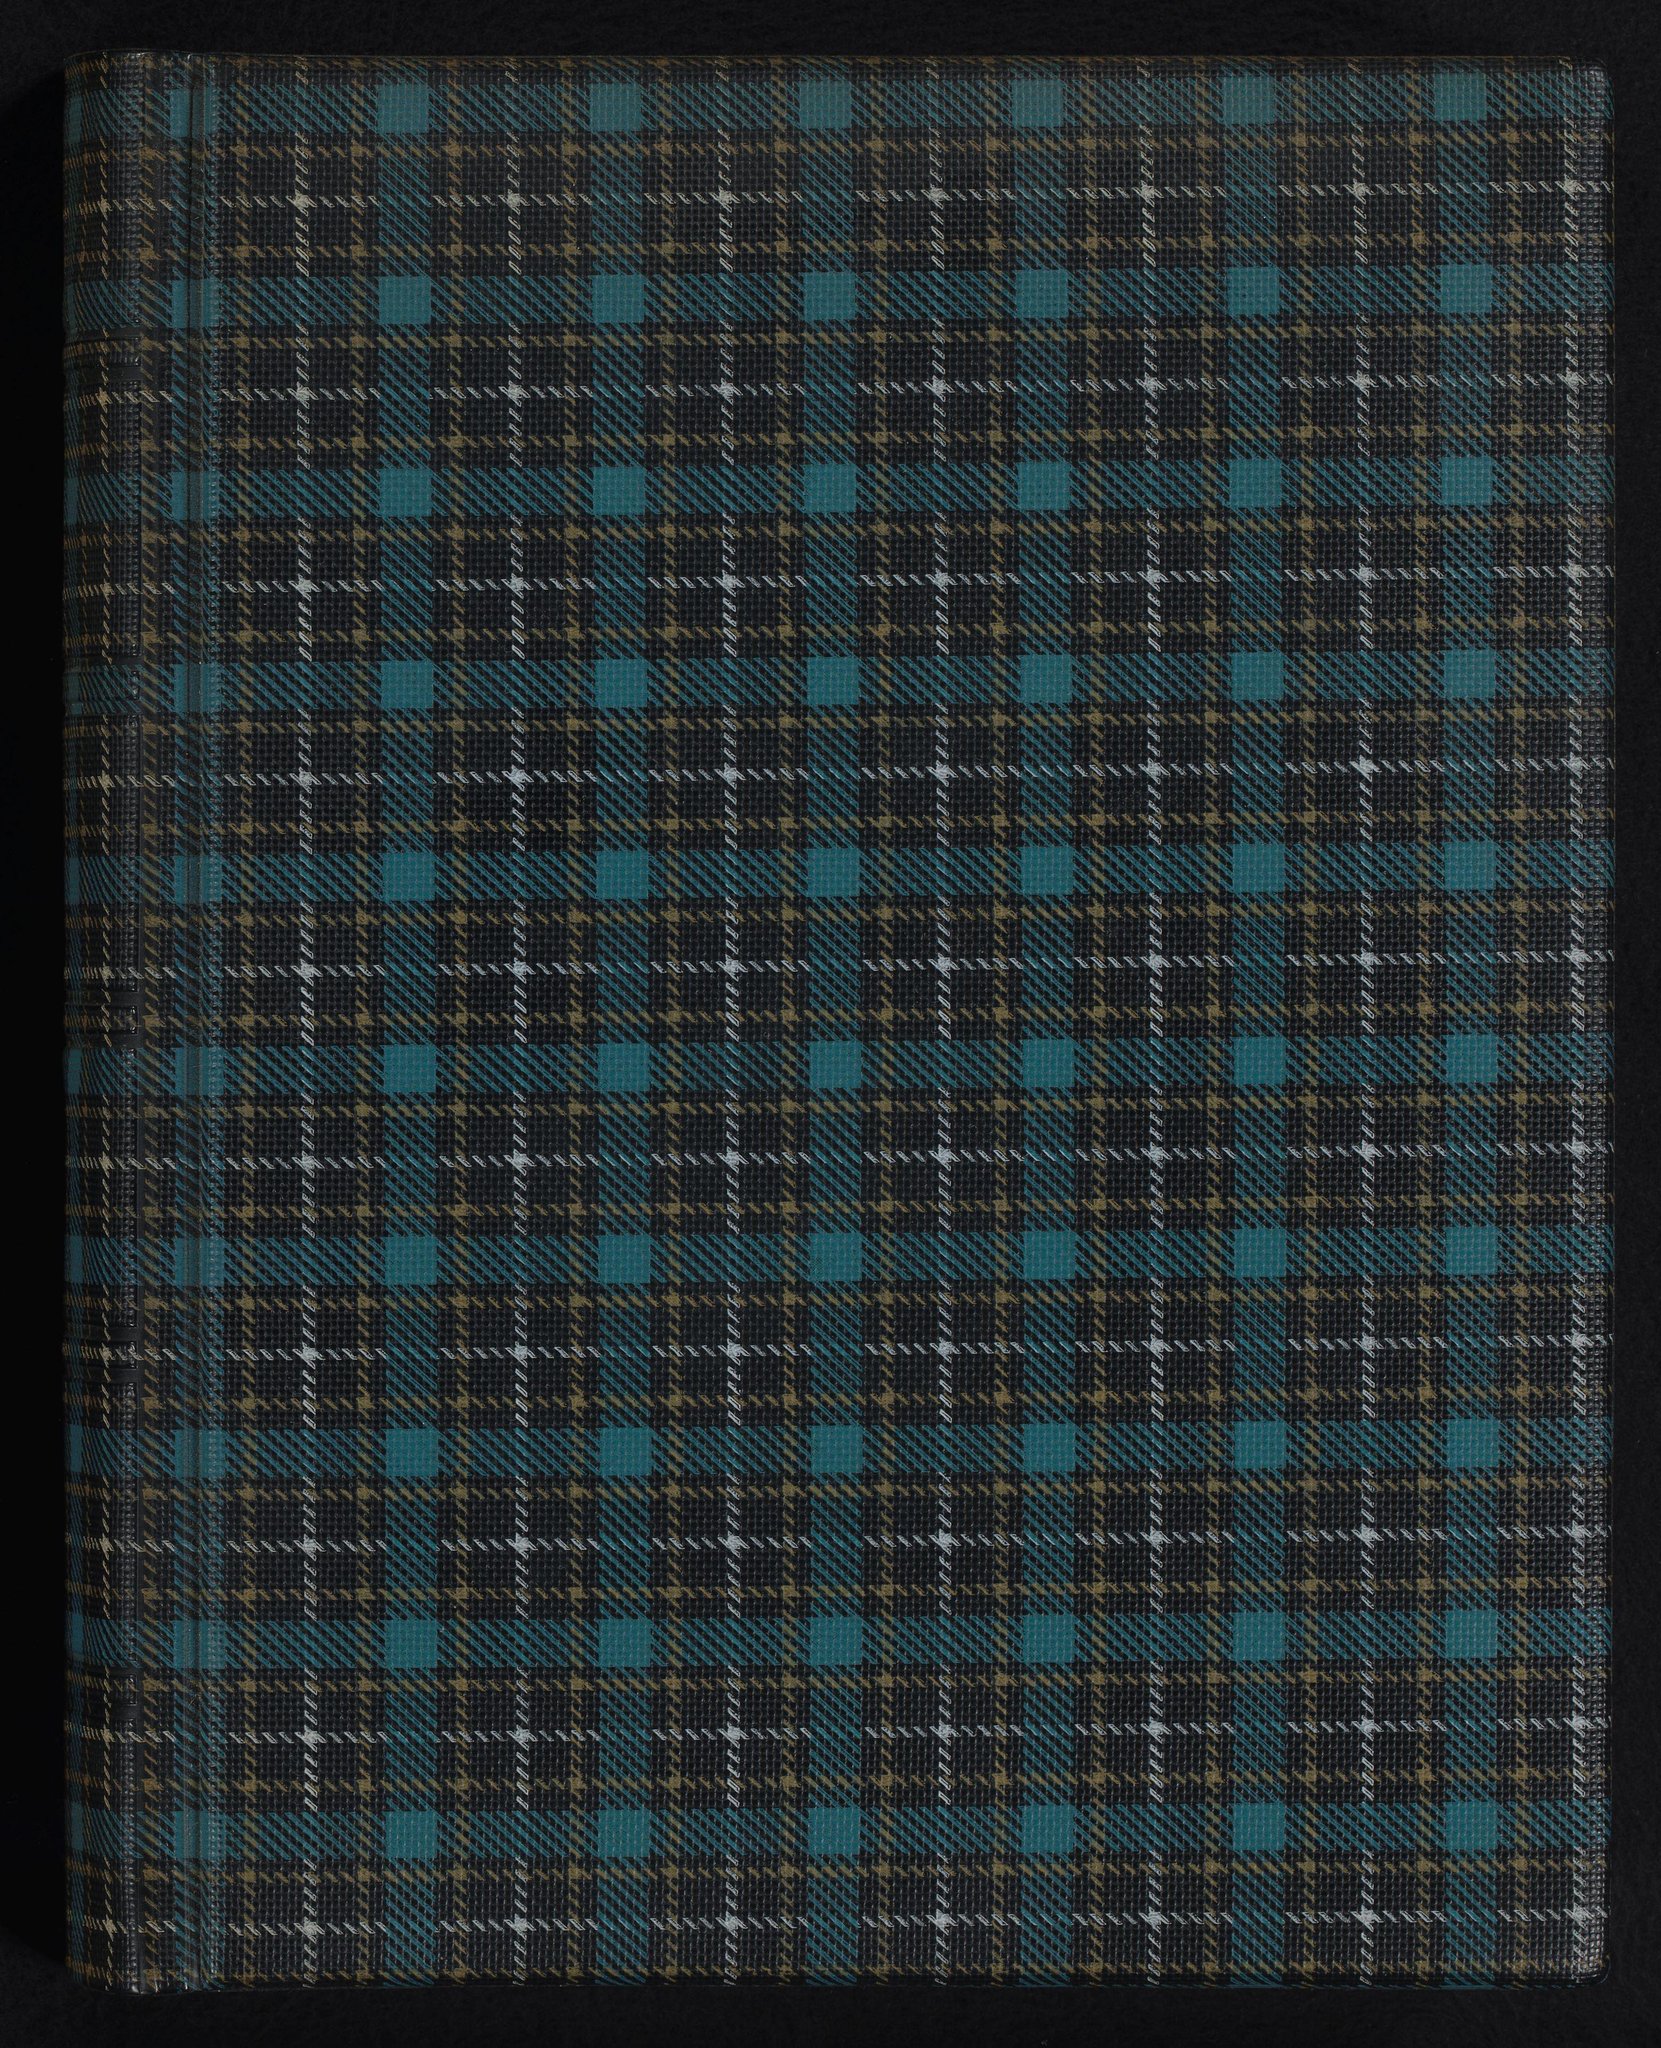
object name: programma, programmaboekje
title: Fotoalbum cabaretvoorstellingen COC 1968-1974, afdeling Den Haag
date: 1968-1974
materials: cardboard, paper, photographic support, plastic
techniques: gelatin silver print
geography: the hague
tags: the hague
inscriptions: stamp: ‘Foto Cees Bolier, Wormerveerstraat 111, Den Haag ...’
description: Fotoalbum van het COC met foto's van cabaretvoorstellingen opgevoerd door de afdeling Den Haag van het COC in de periode 1968-1974. Album met omslag van blauw-grijs geruit plastic. Het album bevat 38 kartonnen bladen met beschermpapier ertussen. In totaal bevat het album 102 foto's en 14 andere objecten zoals brieven, krantenartikelen en programma's. Foto's tonen het repeteren en uitvoeren van cabaretvoorstellingen met titels als 'Protest', 'The Private Ear' en 'Lieve Neef, Lieve Nicht'. De voorstellingen zijn opgevoerd in de periode1968 tot vermoedelijk 1974. Het cabaret werd opgevoerd in Rotterdam, Den Haag en Utrecht, soms samen met een NVSH-lezing. De laatste pagina's bevatten foto's in kleur. In de eerste helft van het album zijn de foto's voorzien van een stempel van Cees Bolier te Den Haag.